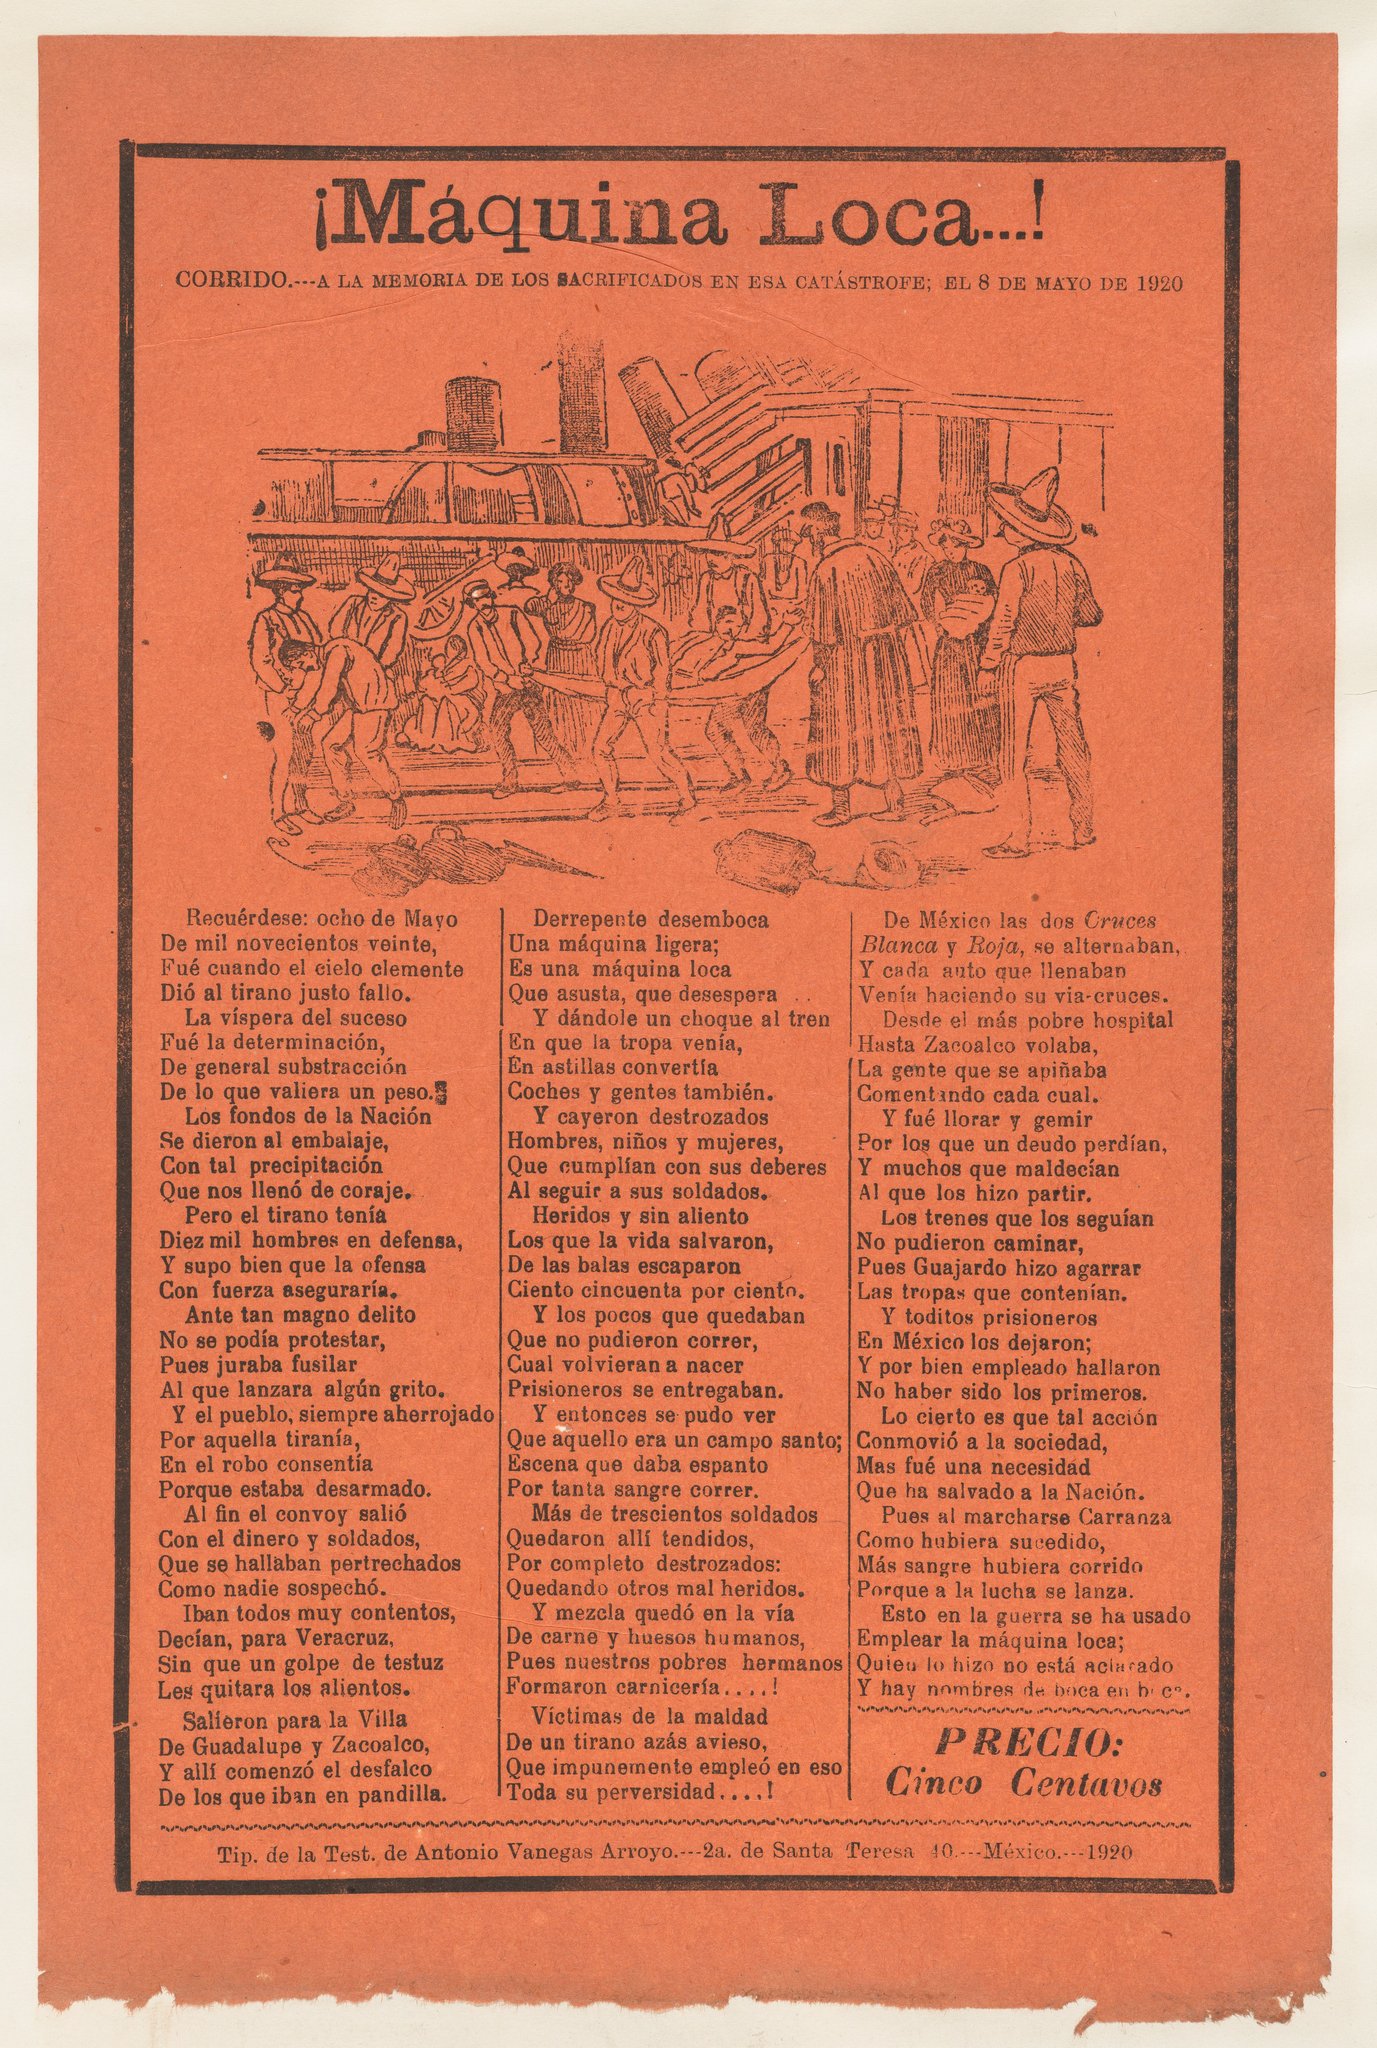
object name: print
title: Broadsheet relating to a train accident that killed many people, wounded victims being carried on stretchers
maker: josé guadalupe posada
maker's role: artist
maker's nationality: mexican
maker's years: 1852-1913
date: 1920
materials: paper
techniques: letterpress, lithography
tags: men,women,trains